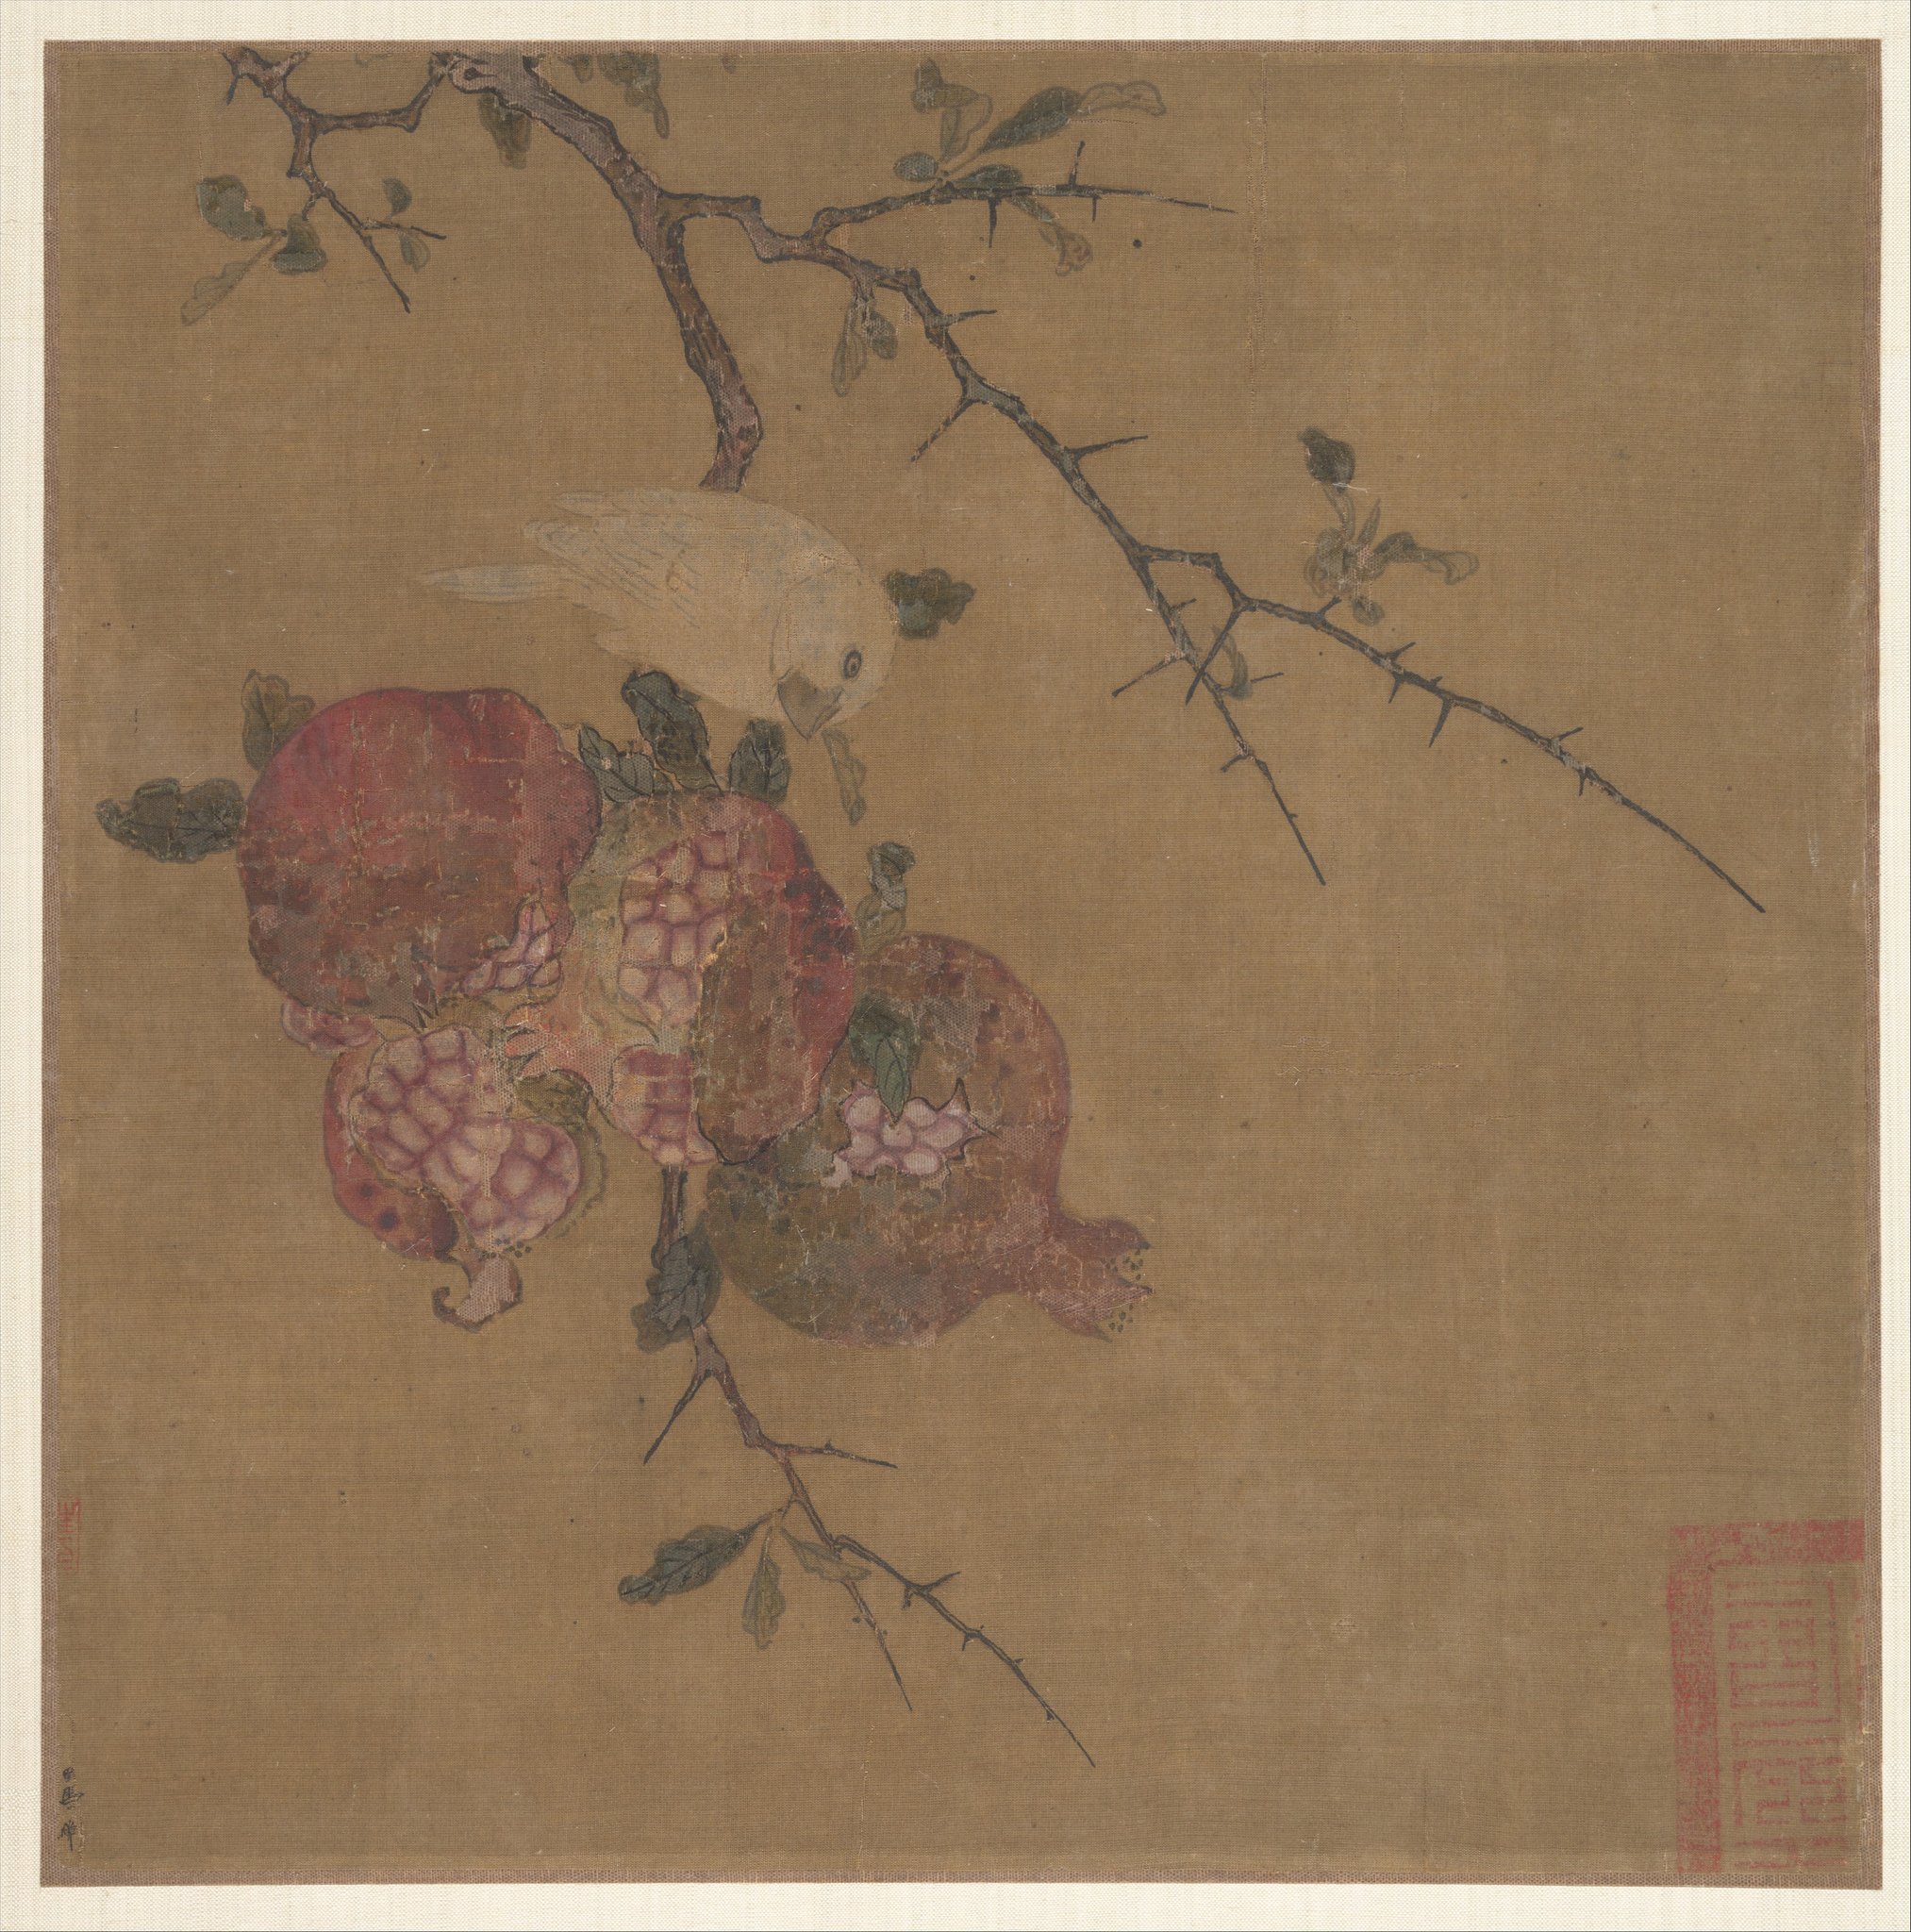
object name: album leaf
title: Pomegranates after Ma Lin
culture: chinese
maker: unidentified artist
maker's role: artist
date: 1368-1911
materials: ink, silk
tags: birds,pomegranates